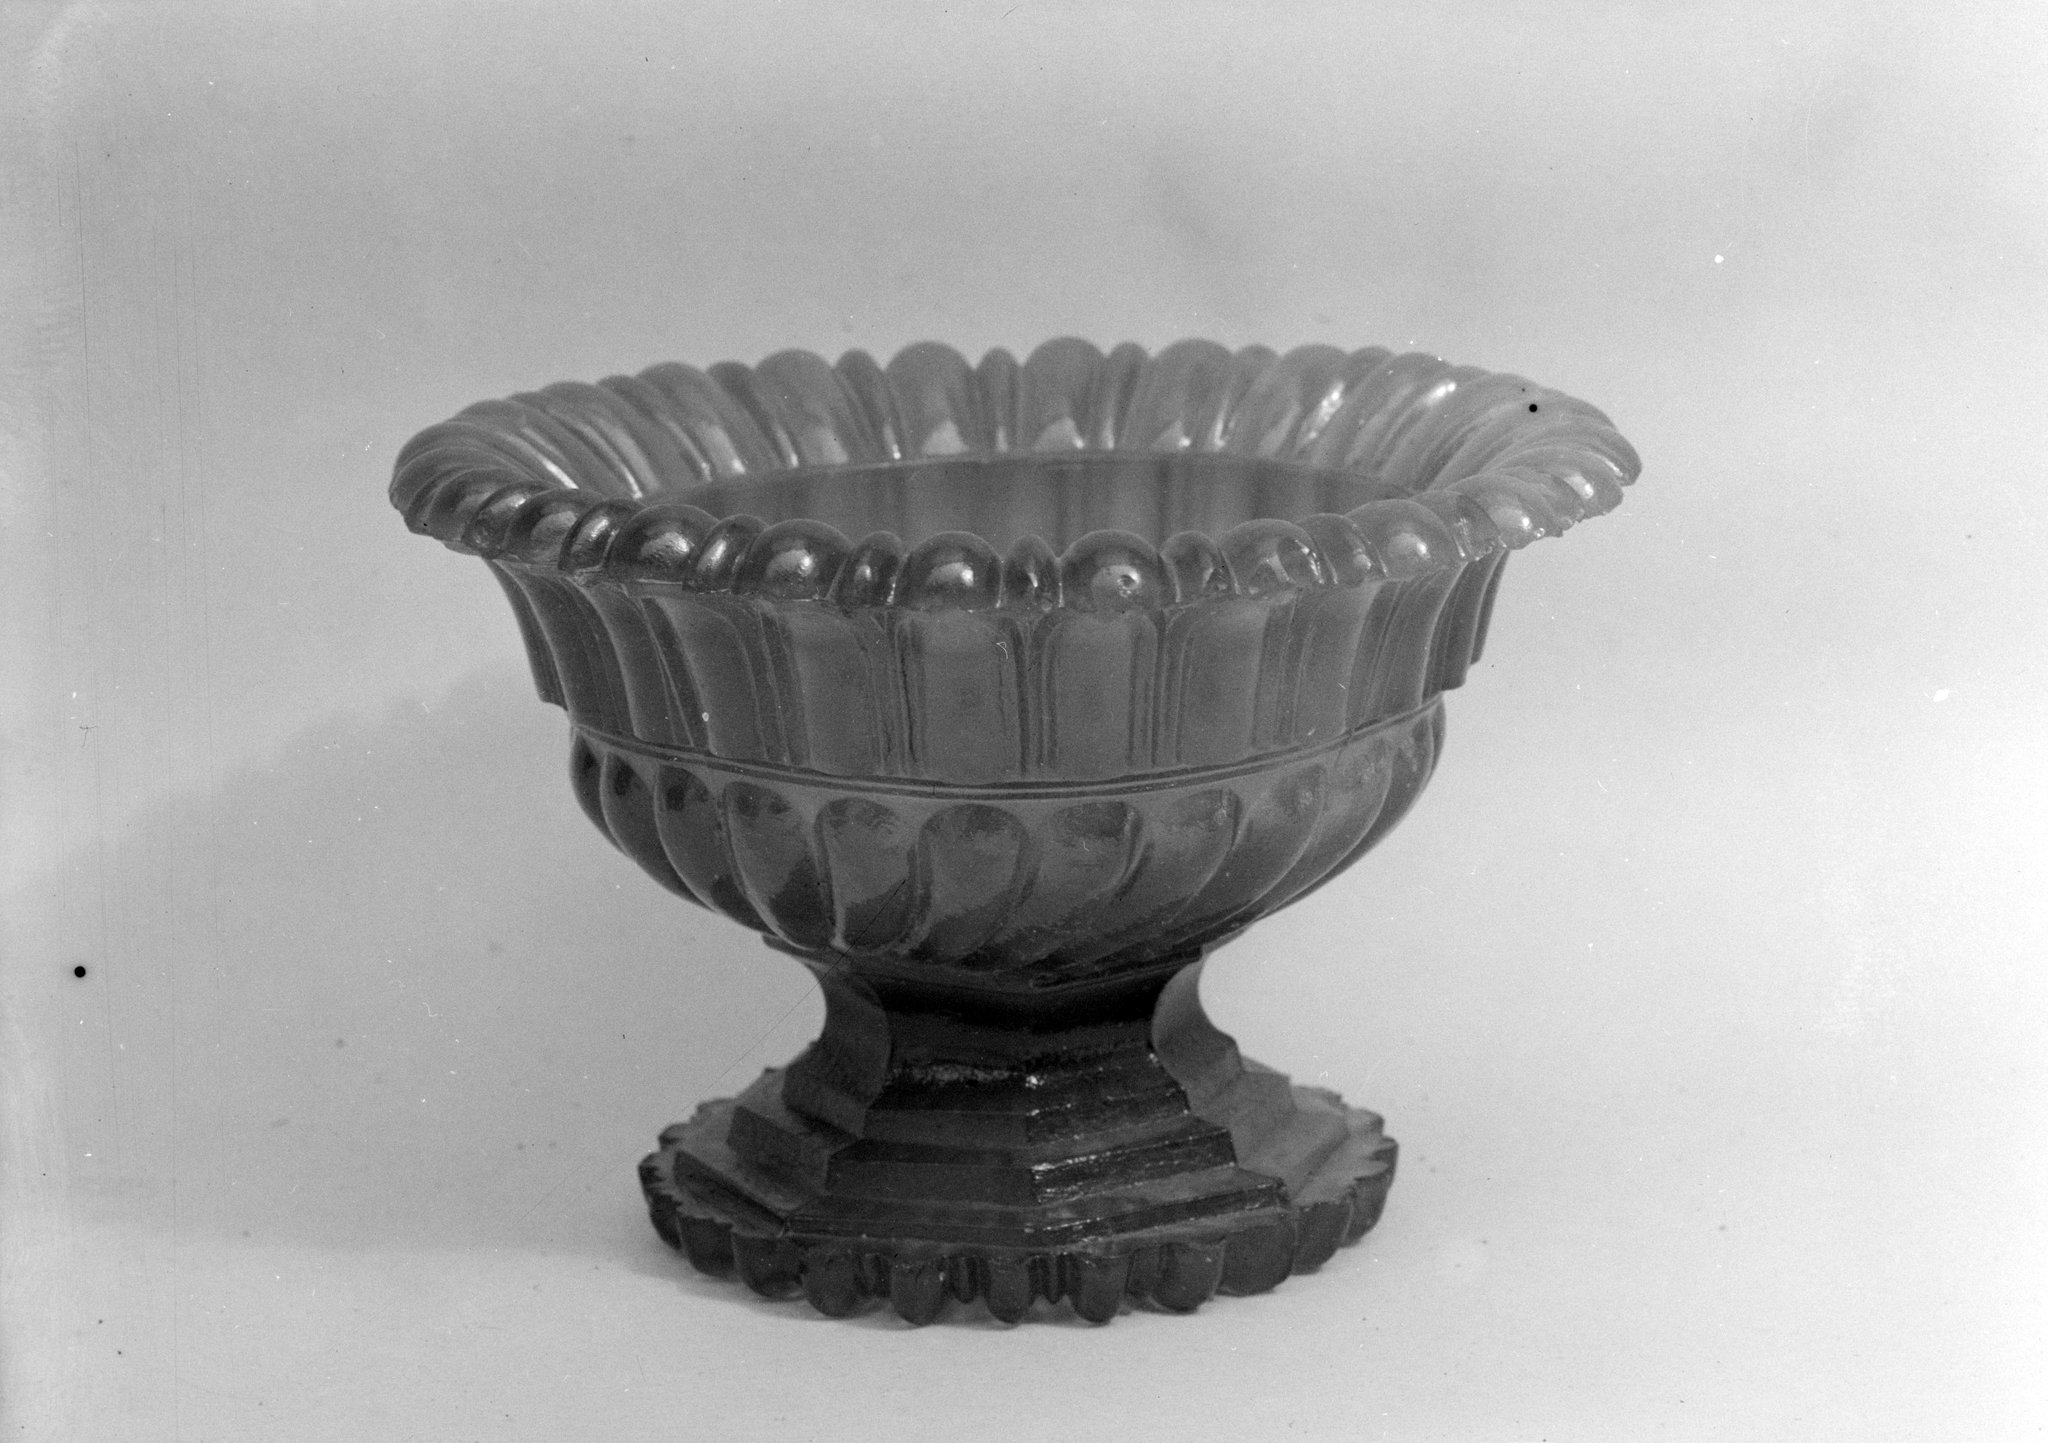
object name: bowl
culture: american or british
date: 1850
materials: glass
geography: england